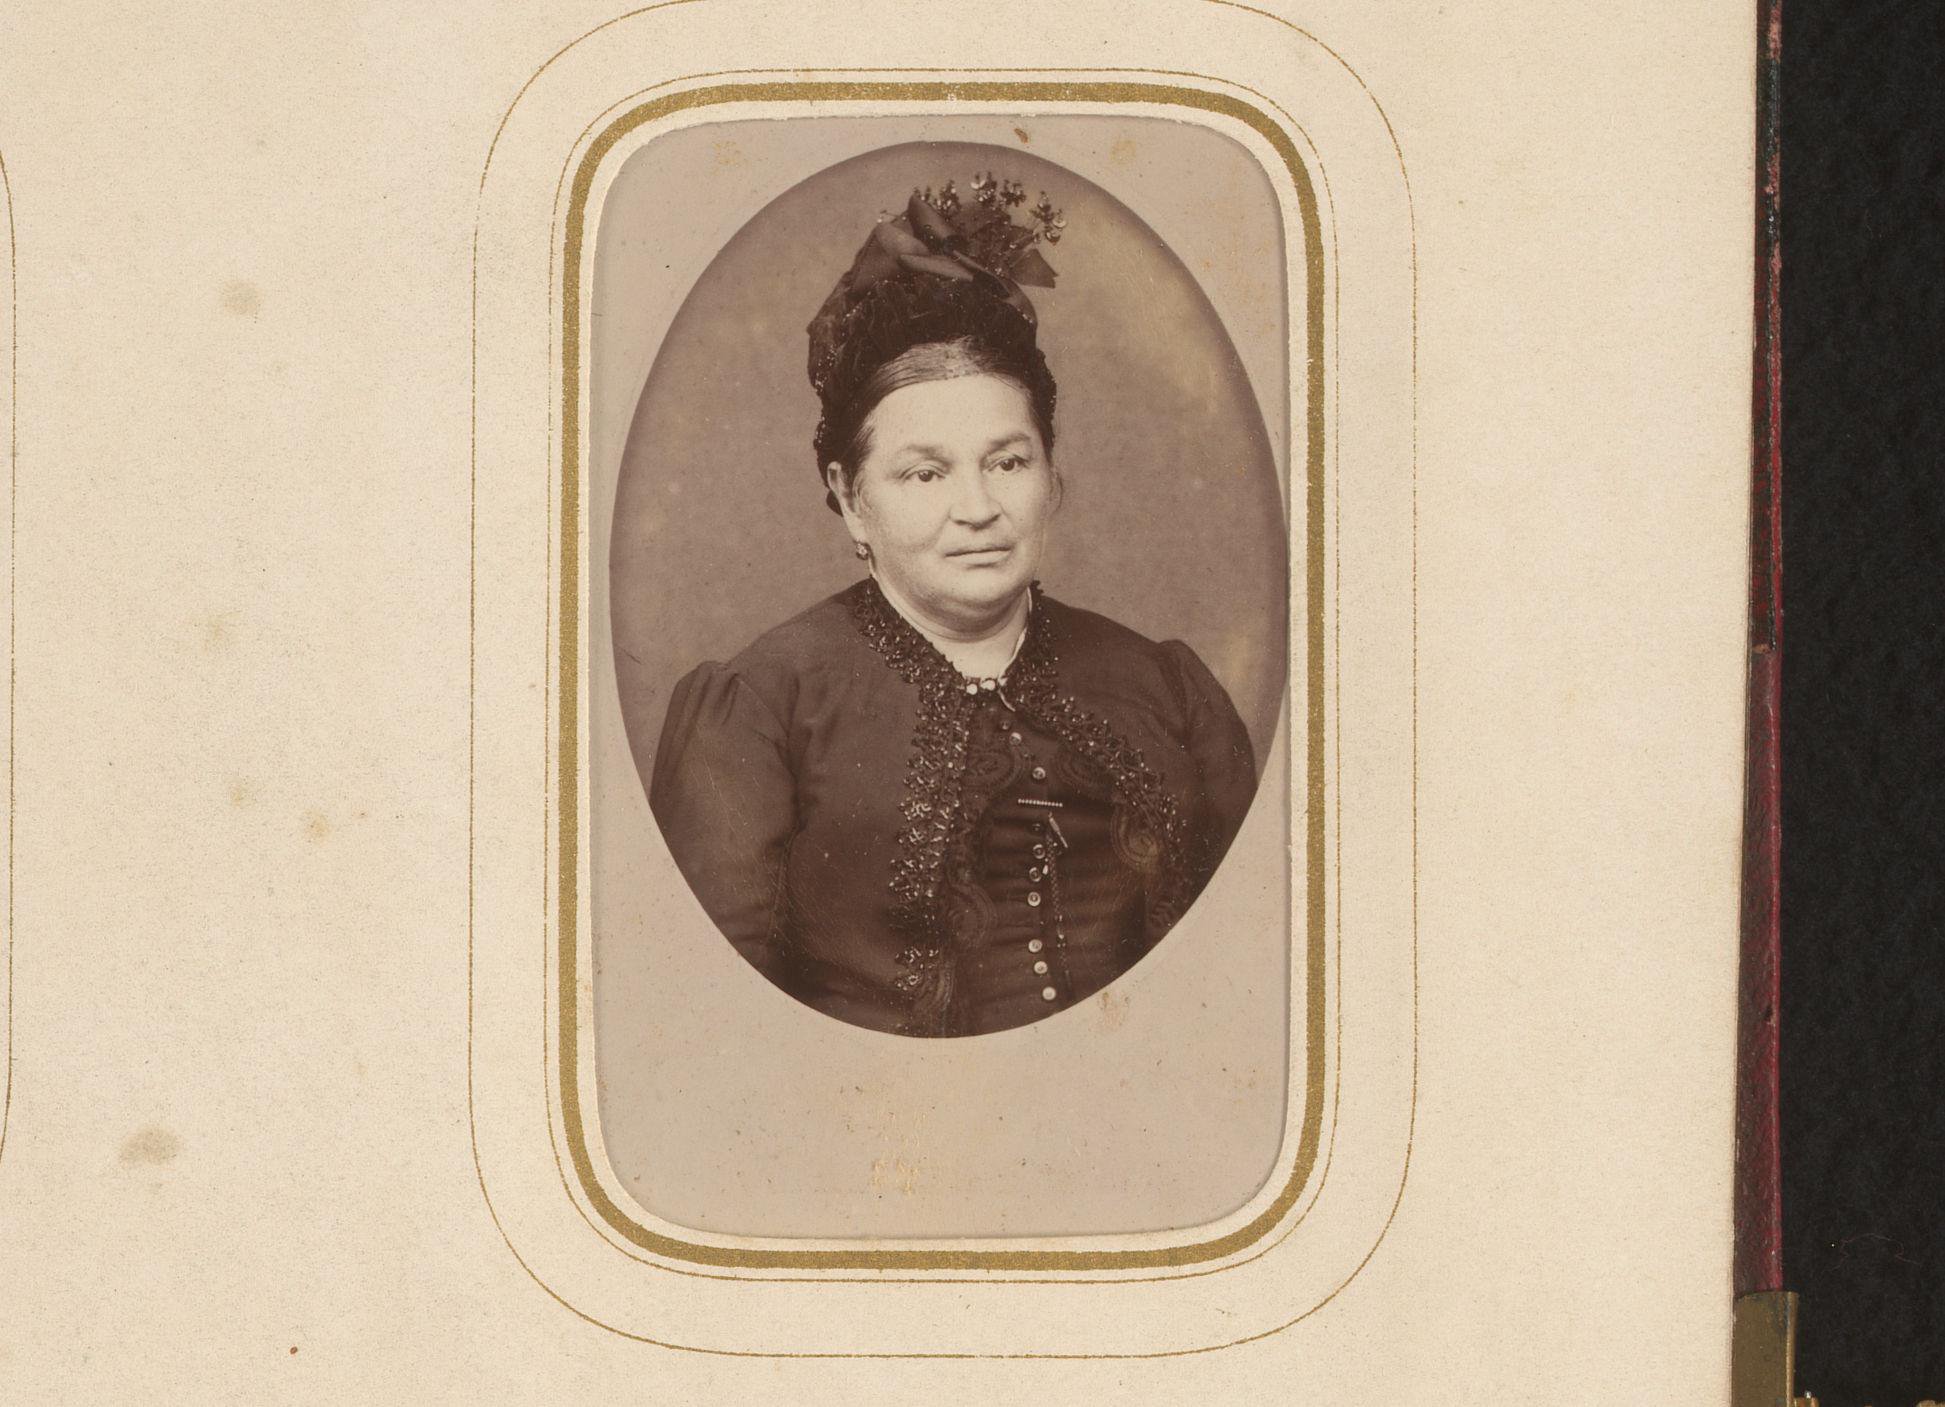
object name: photograph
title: Portret van een vrouw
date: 1885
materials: cardboard, celluloid, photographic support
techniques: albumen print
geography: vichy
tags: historical persons - bb - woman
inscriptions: inscription: ‘Photographie Anglaise/ Vichy 1885’